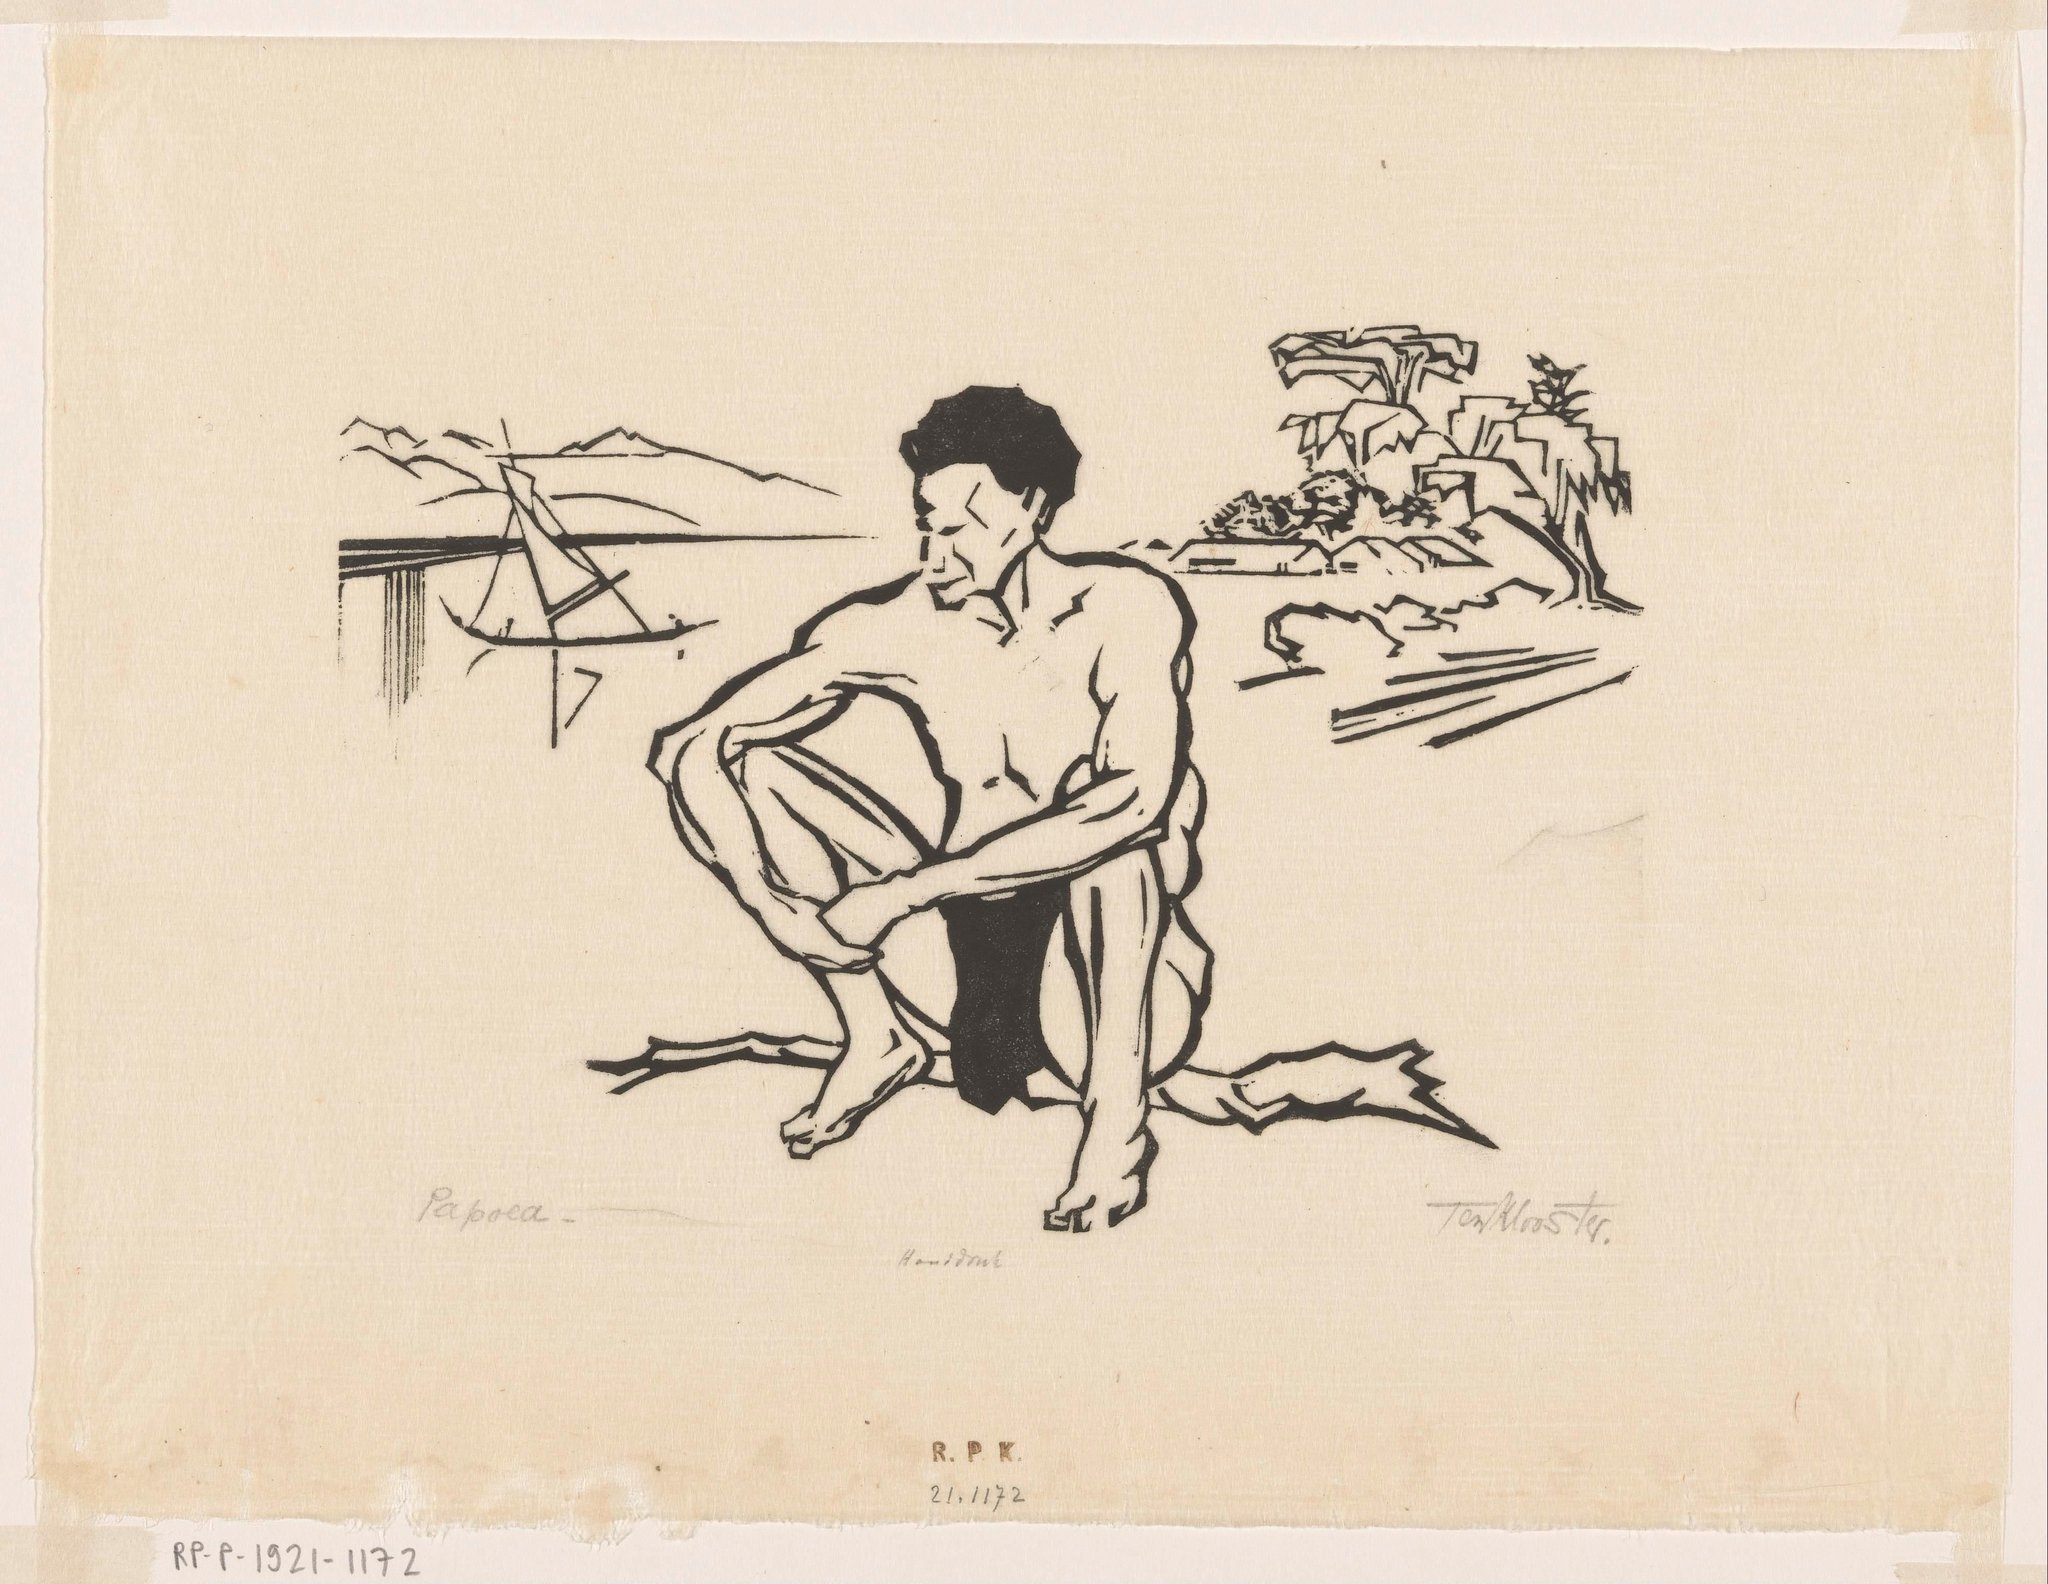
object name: print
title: Papoea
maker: johannes frederik engelbert ten klooster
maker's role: draughtsman, print maker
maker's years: 1873-1940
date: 1919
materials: paper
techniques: woodcut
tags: trees (+ branch, stick), landscapes in tropical and sub-tropical regions, sitting on an elevation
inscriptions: collector's mark: Lugt 2233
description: Een man zittend op een boomtak bij het water. Op de achtergrond bergen, een zeilschip en een nederzetting.